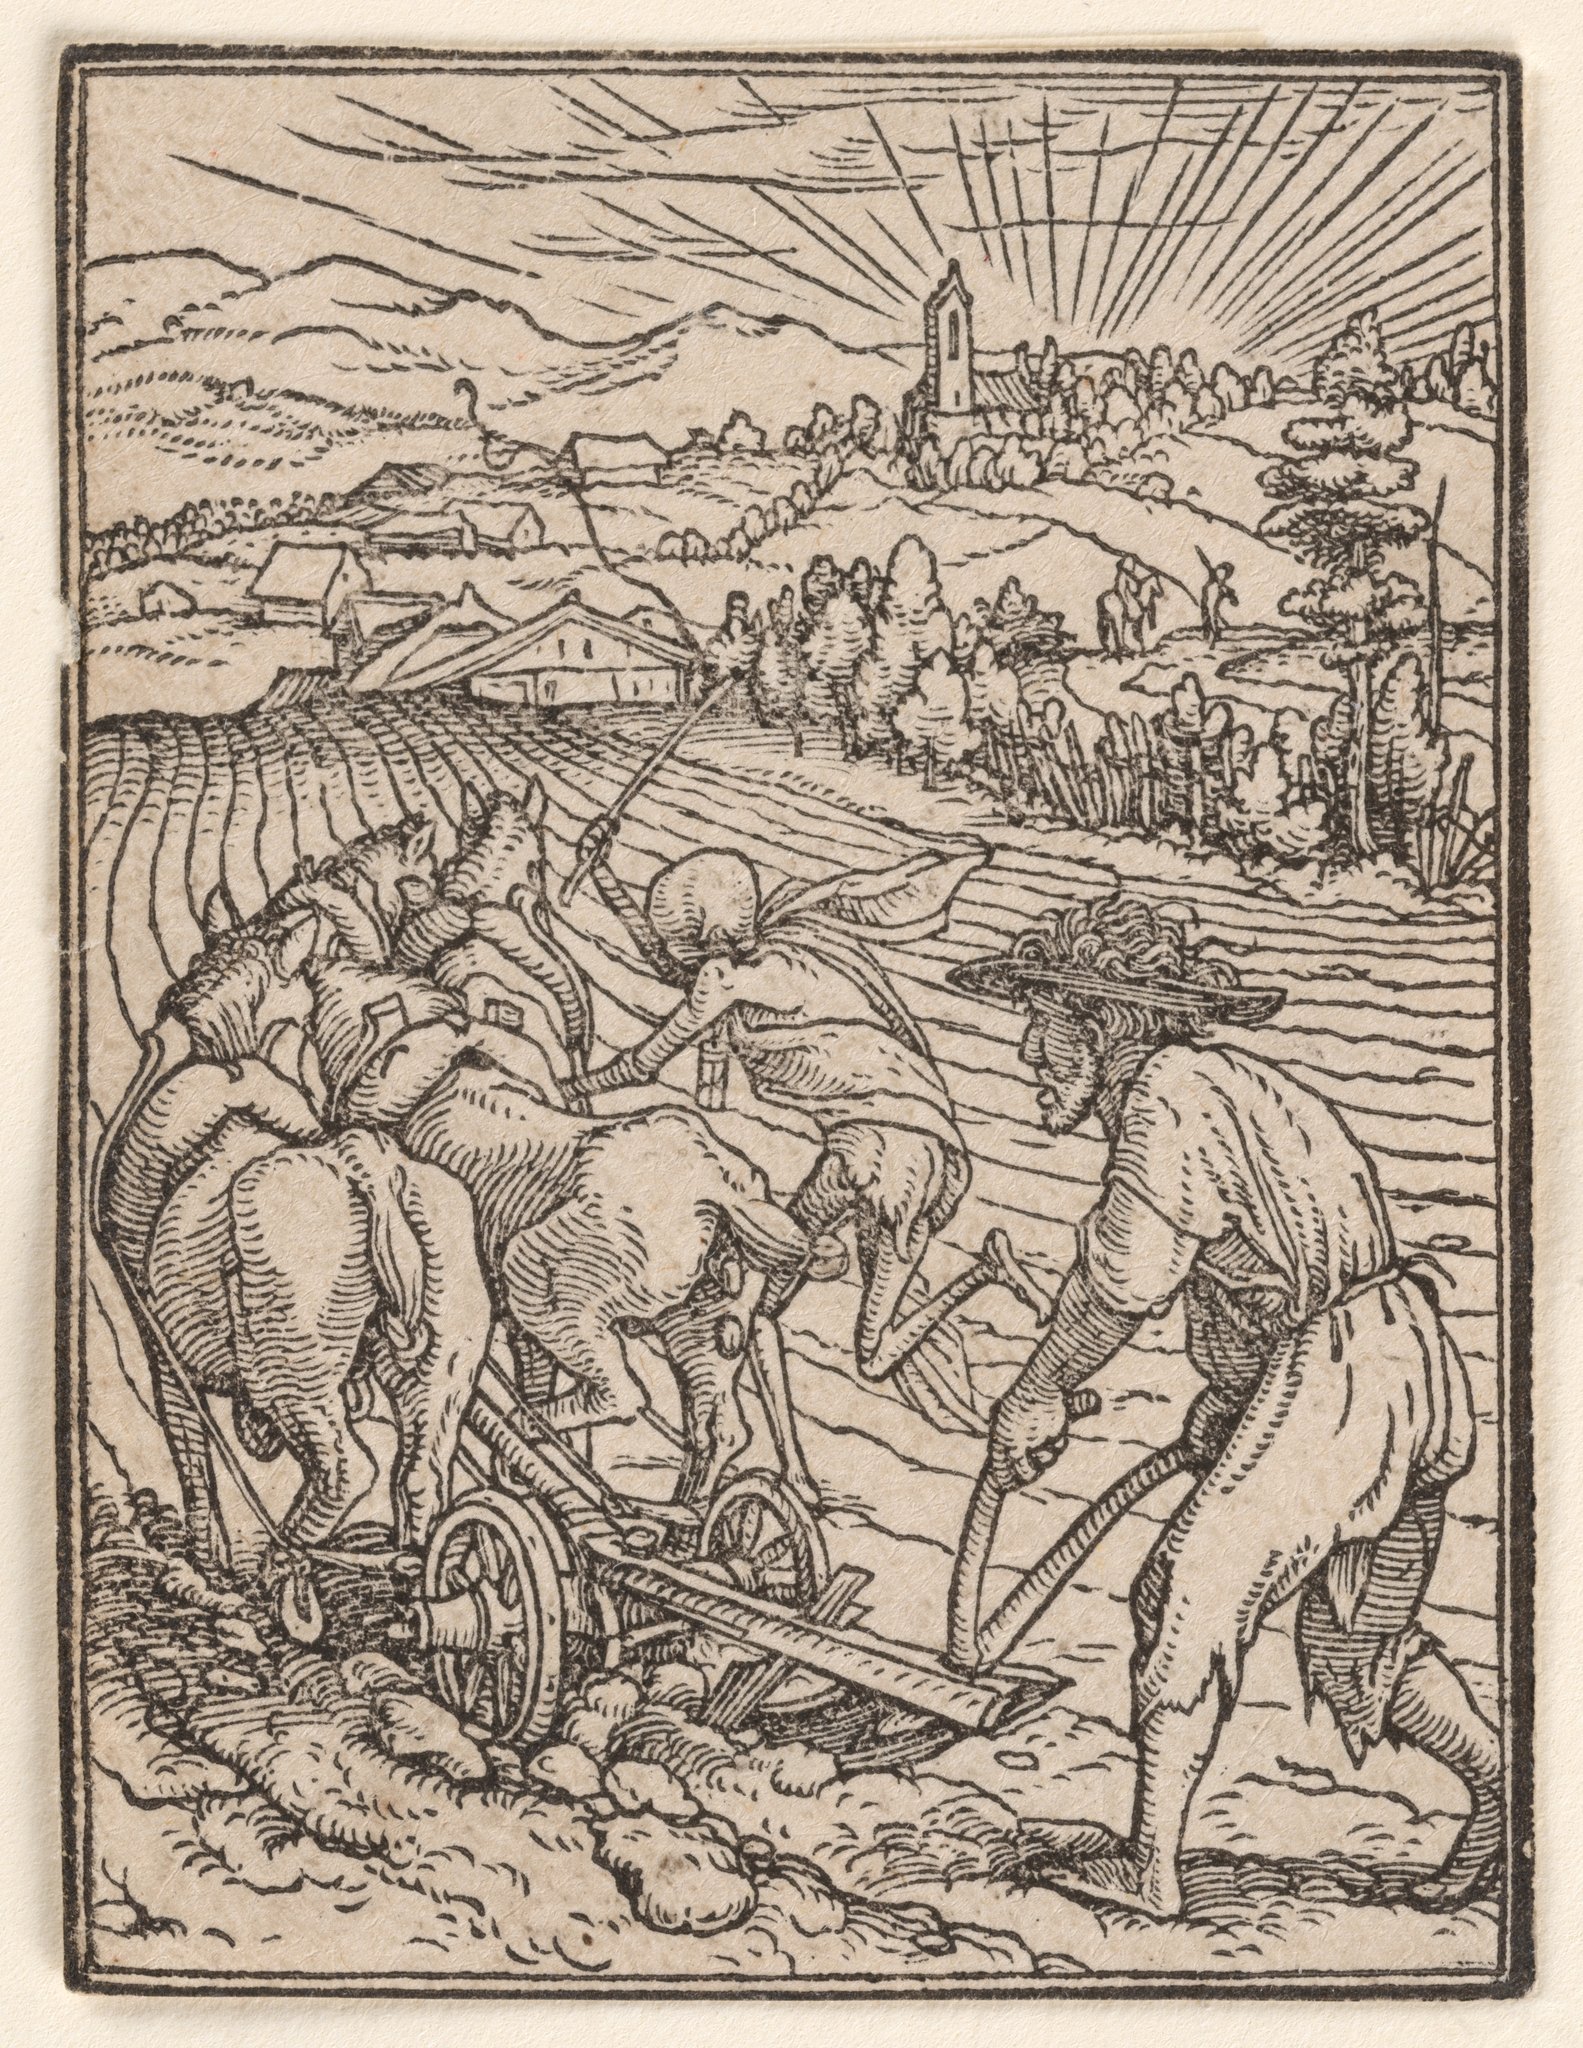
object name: print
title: The Peasant (or Ploughman), from "The Dance of Death"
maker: hans holbein the younger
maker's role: artist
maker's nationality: german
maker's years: 1497-1543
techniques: woodcut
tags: farms,skeletons,horses,plows